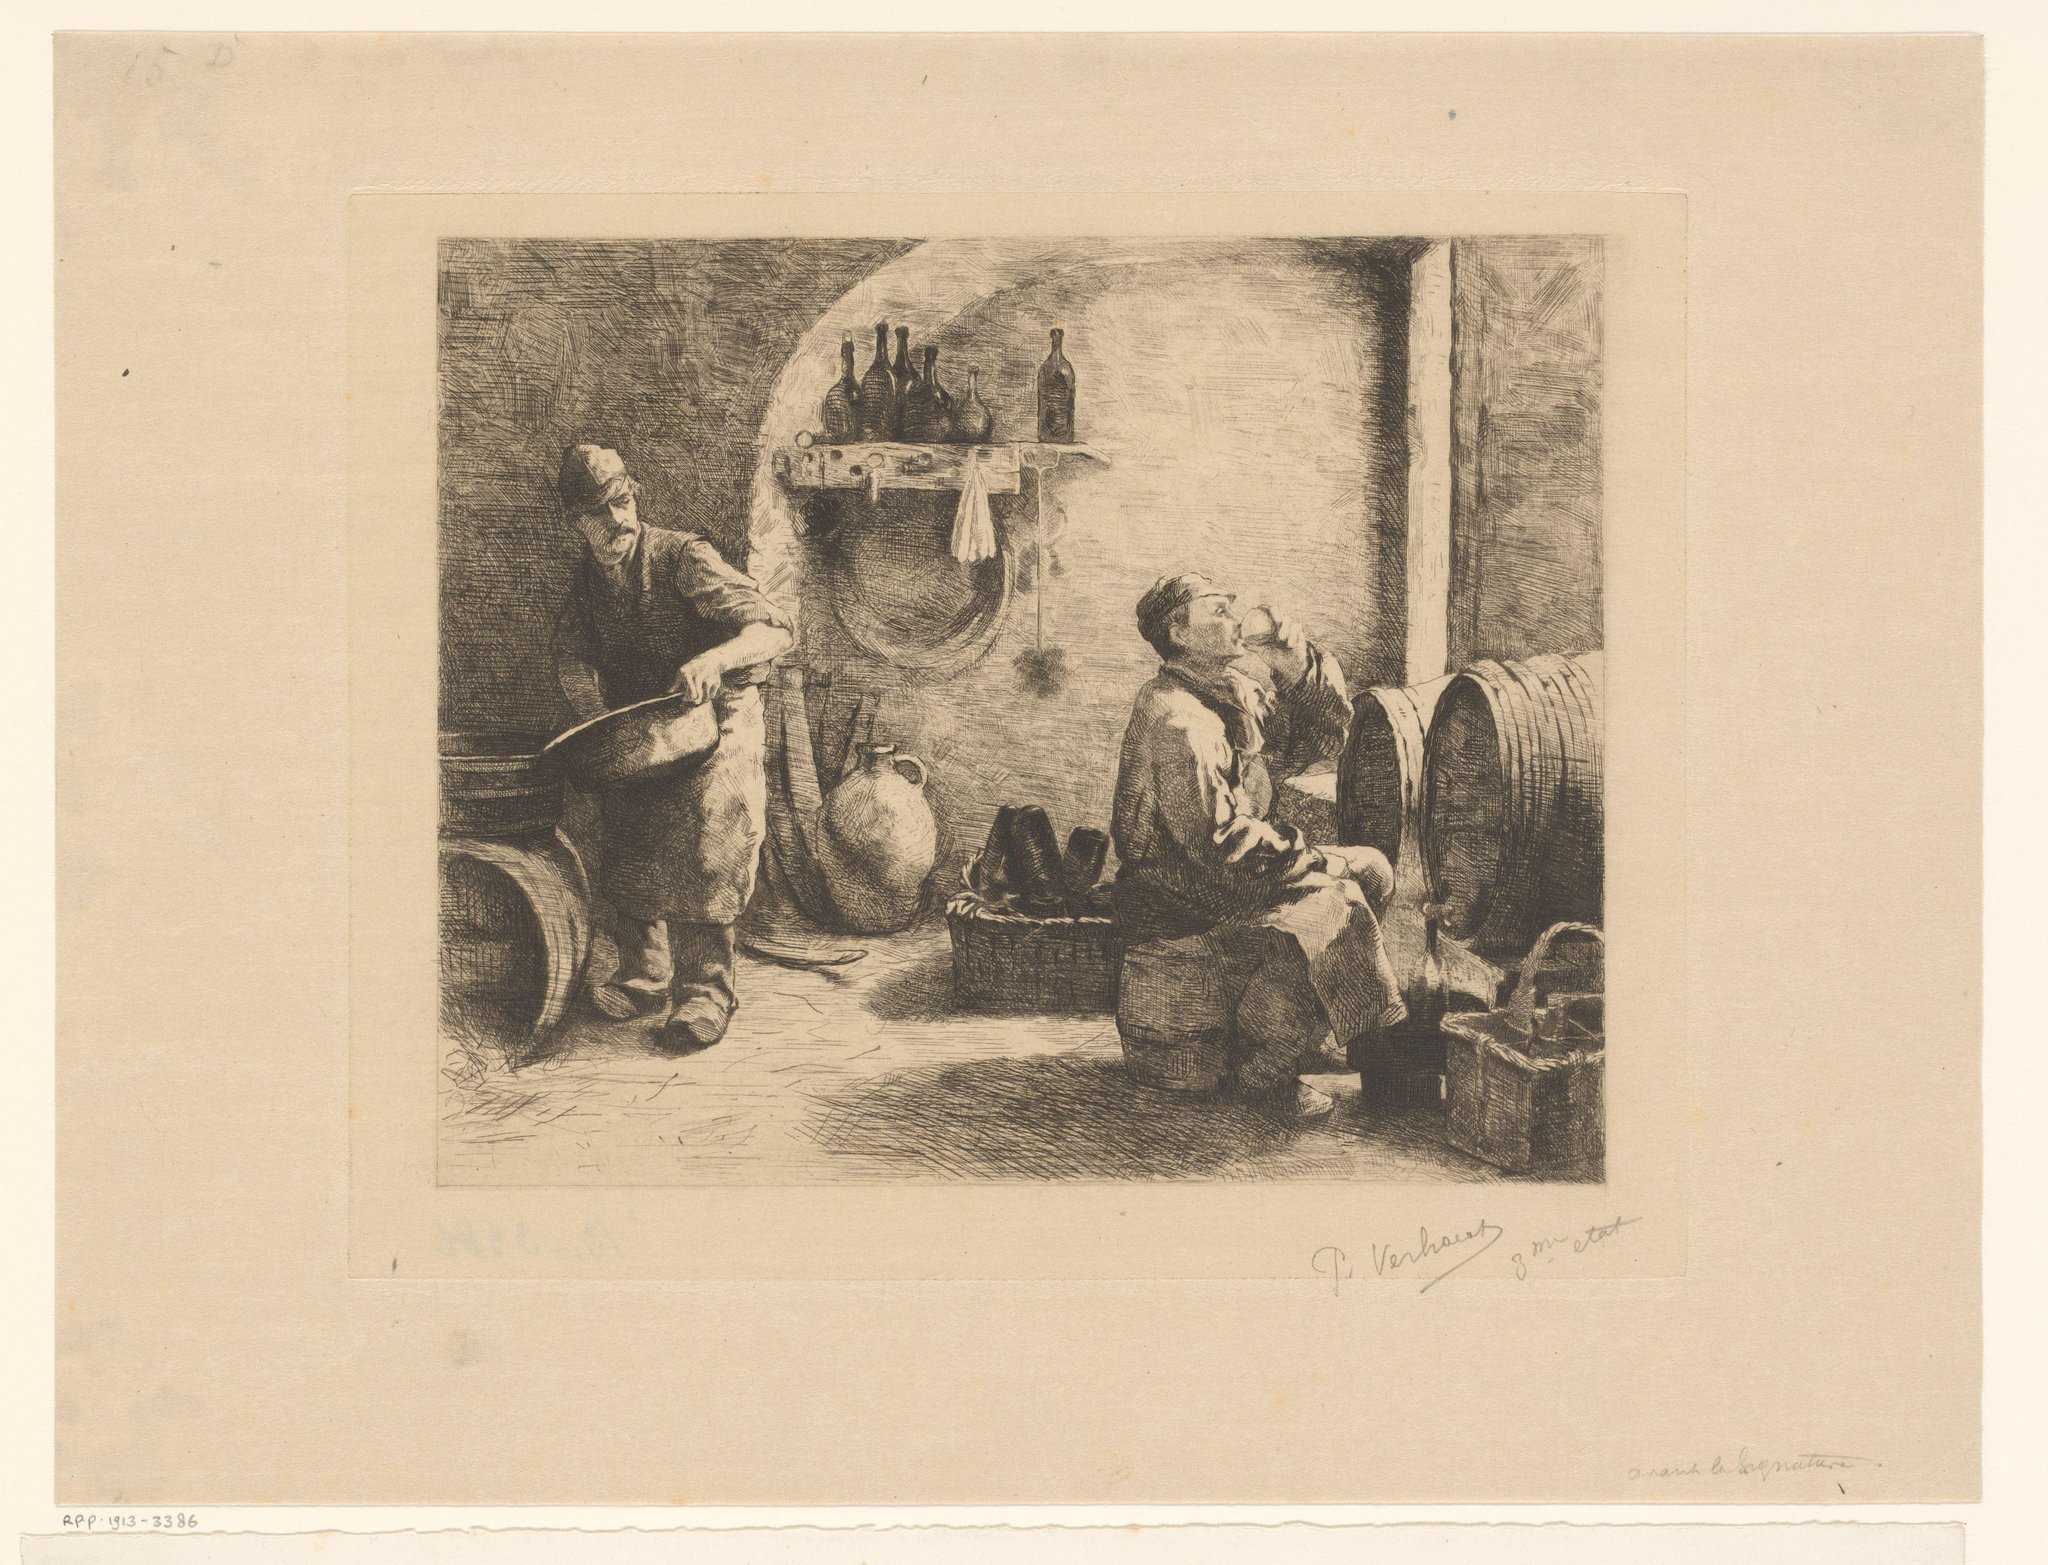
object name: print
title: Twee bottelaars in hun werkplaats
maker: piet verhaert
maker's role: print maker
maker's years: 1852-1908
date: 1880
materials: paper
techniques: etching, retroussage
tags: container of glass: bottle, jar, vase, workshop-interior, basement, cellar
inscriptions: collector's mark: Lugt 2228